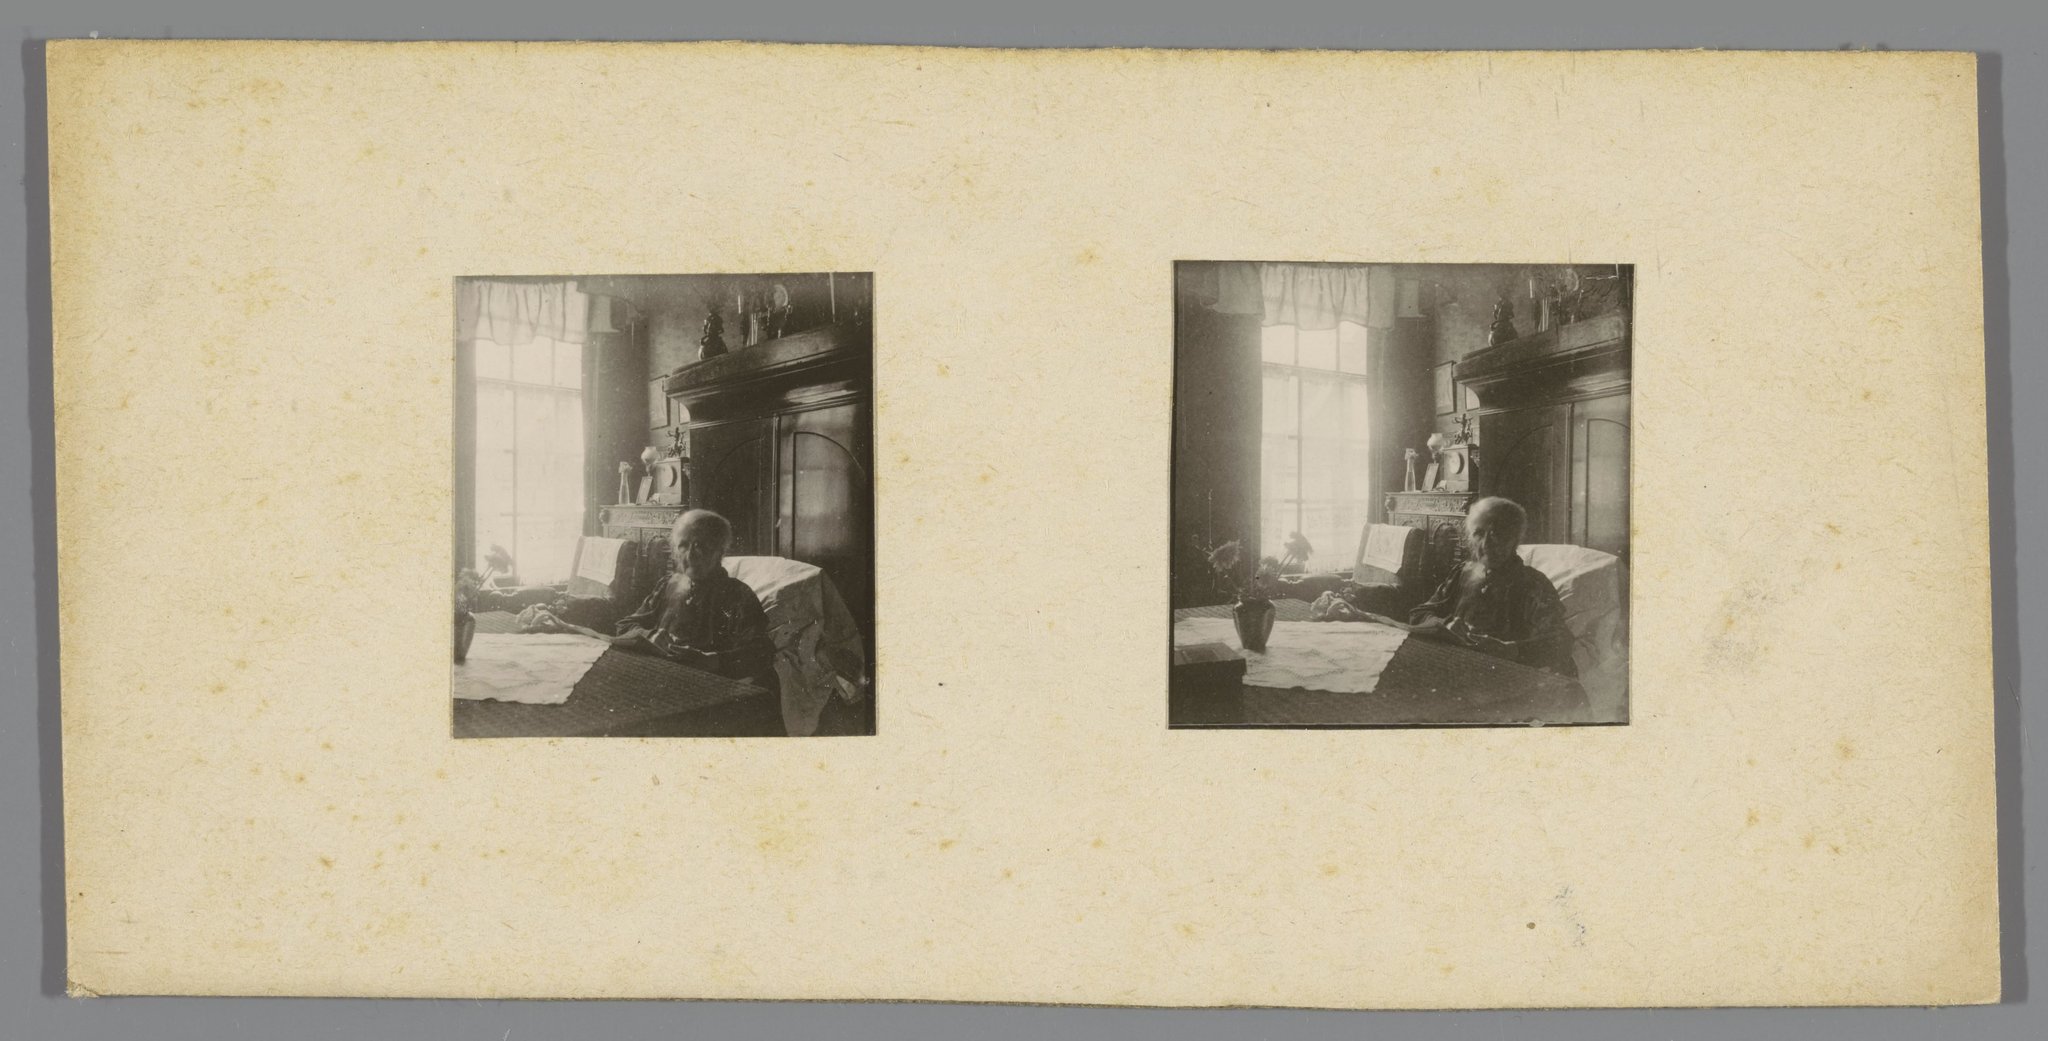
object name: stereograph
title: Portret van een onbekende oude vrouw met krant aan tafel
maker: Anonymous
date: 1900-1940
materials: paper, cardboard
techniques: gelatin silver print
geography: netherlands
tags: historical persons not known by name - bb - woman, old woman, newspaper, news-sheet, living-room, parlour, sitting-room